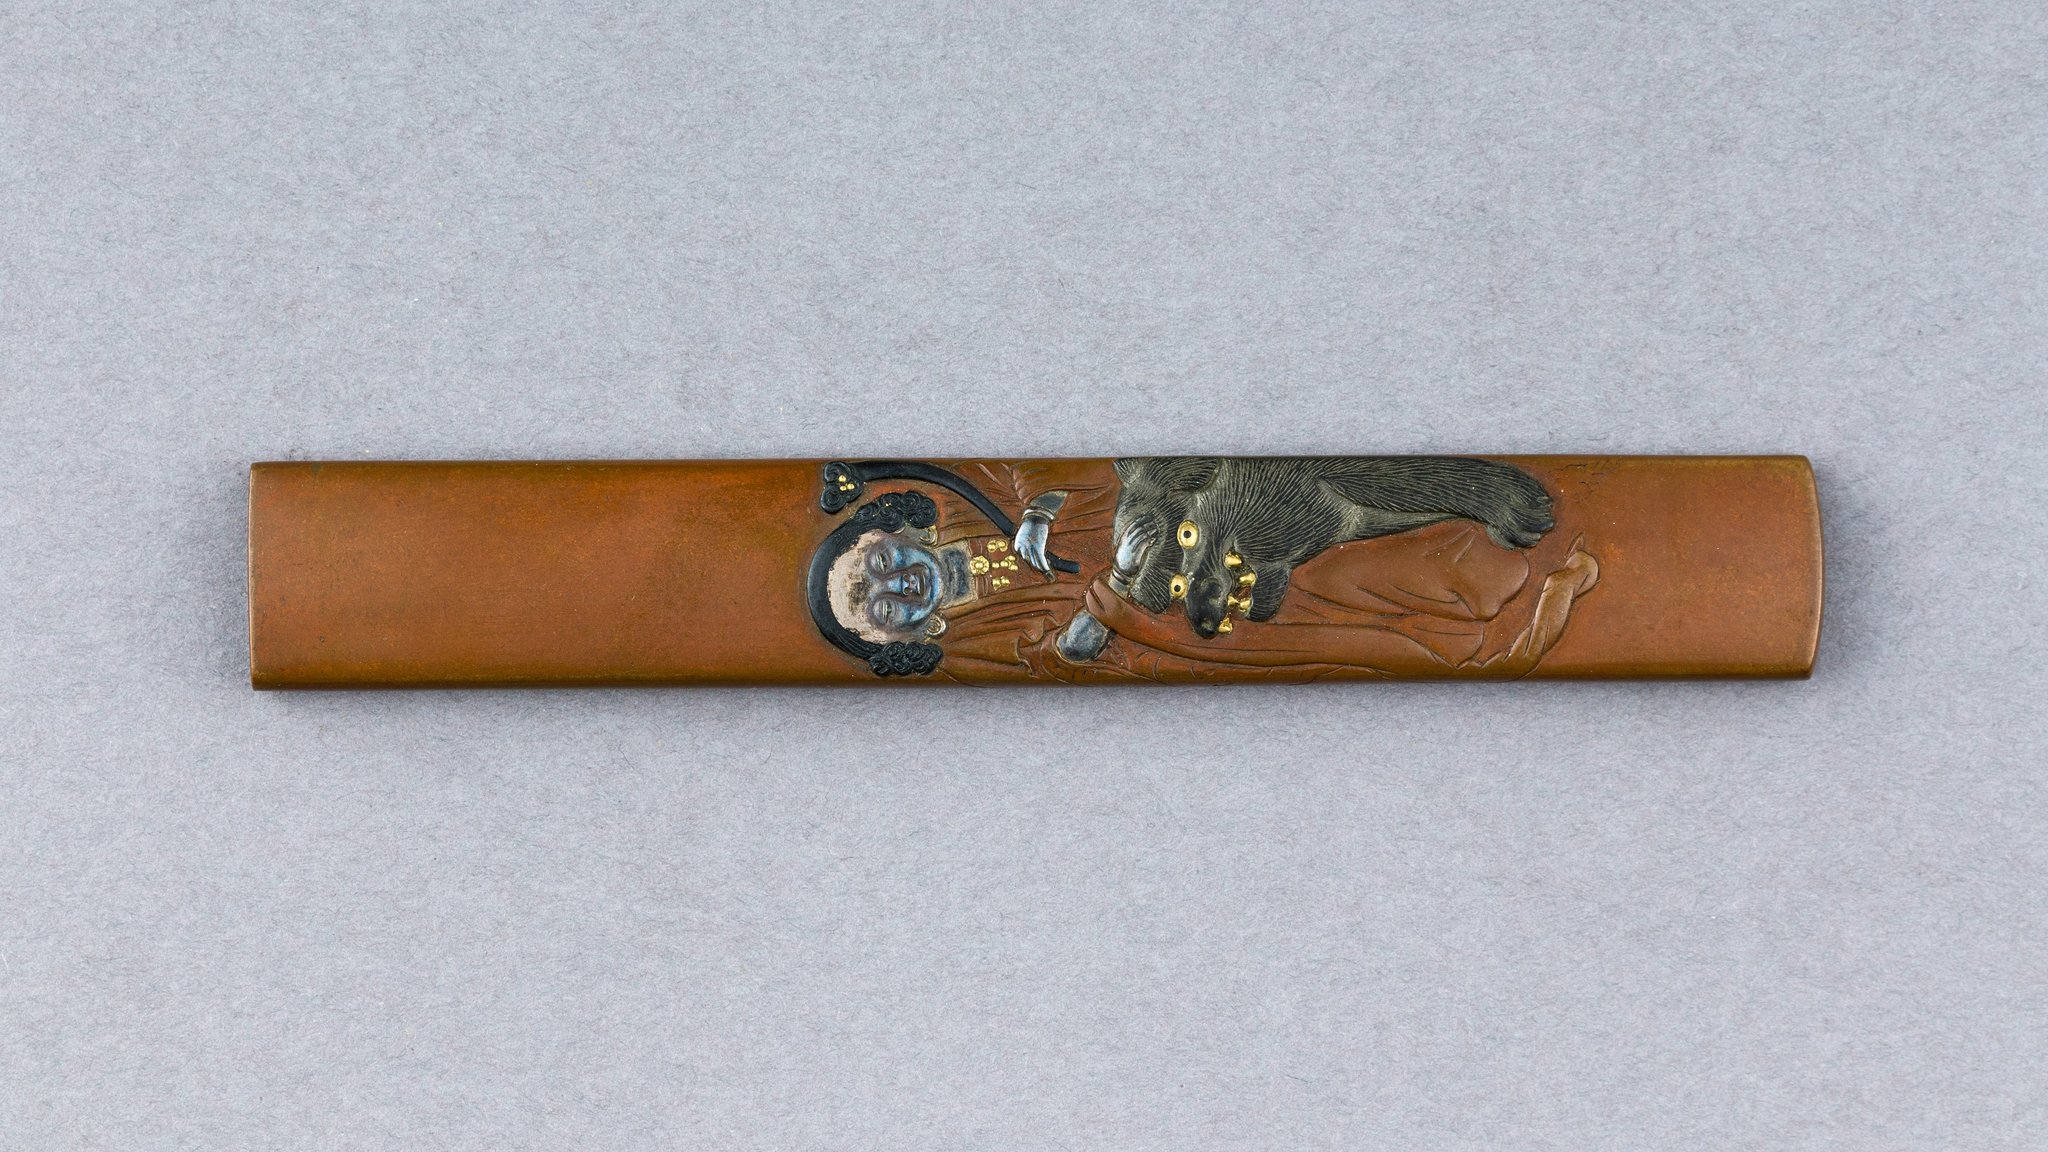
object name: knife handle kozuka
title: Knife Handle (Kozuka)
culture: japanese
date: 1615-1868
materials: copper, gold alloy, silver alloy, gold, silver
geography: japan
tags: human figures,animals